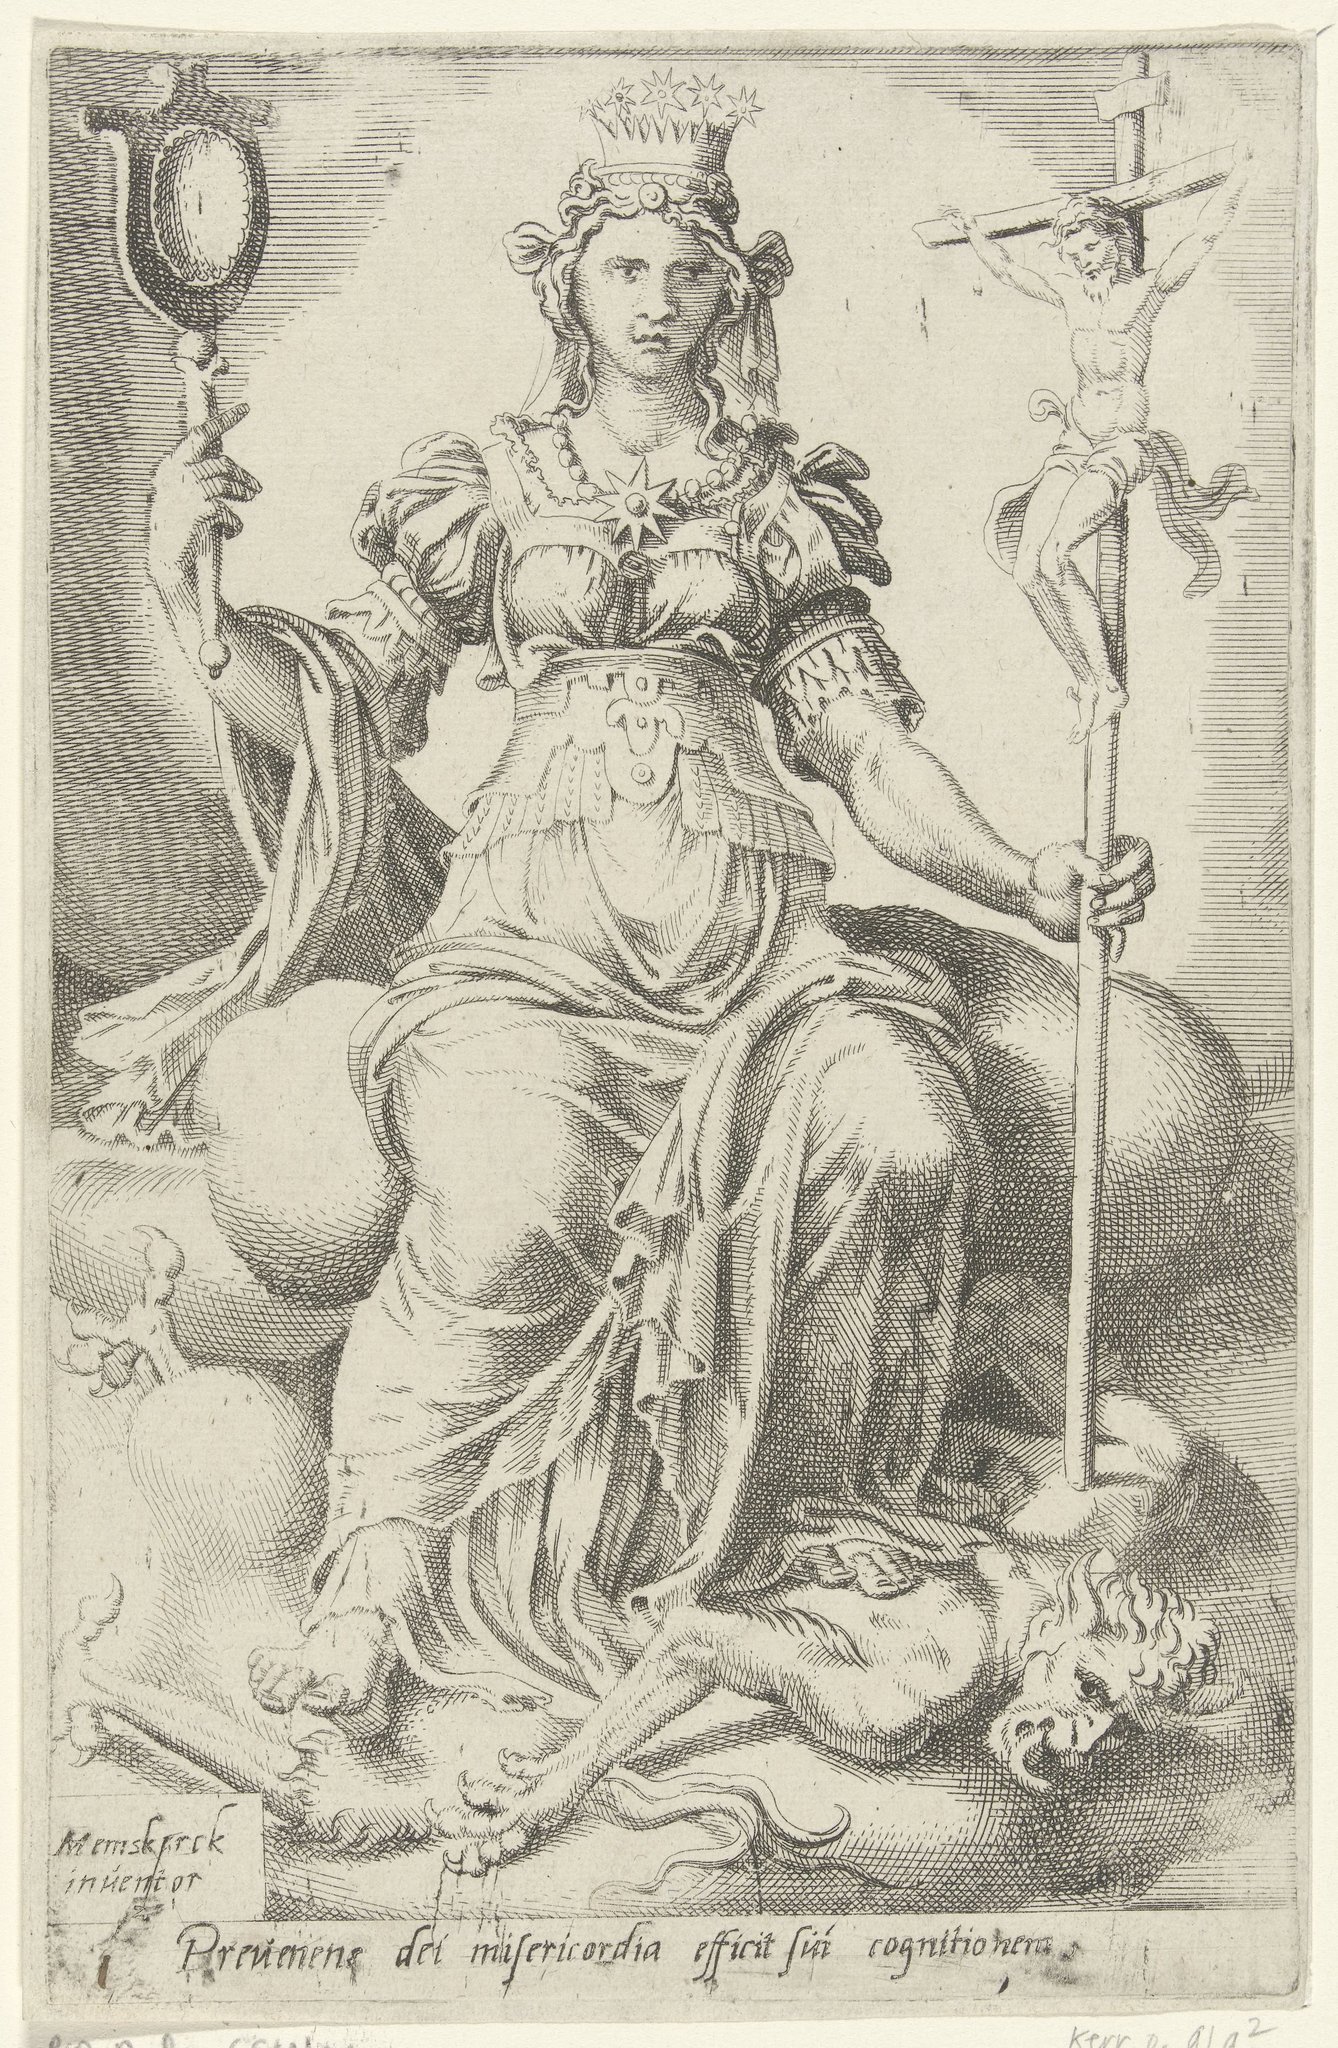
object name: print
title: Jakobs ladder of de allegorie van de weg naar eeuwige zaligheid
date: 1550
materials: paper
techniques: etching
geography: haarlem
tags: mirror, eternal bliss; 'felicità eterna' (ripa) (+ symbolical representation of concept), divine decree of redemption, allegorical figures present, e.g. justice, mercy, peace and truth (the virtues reconciled) (+ devil(s))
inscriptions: collector's mark: Lugt 2228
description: De personificatie van Gods Genade. Zij vertrapt een duivel. Gods Genade houdt de spiegel van zelfkennis vast. De prent heeft een Latijns onderschrift en maakt deel uit van een veertiendelige serie met als onderwerp de manier om eeuwige zaligheid te bereiken.